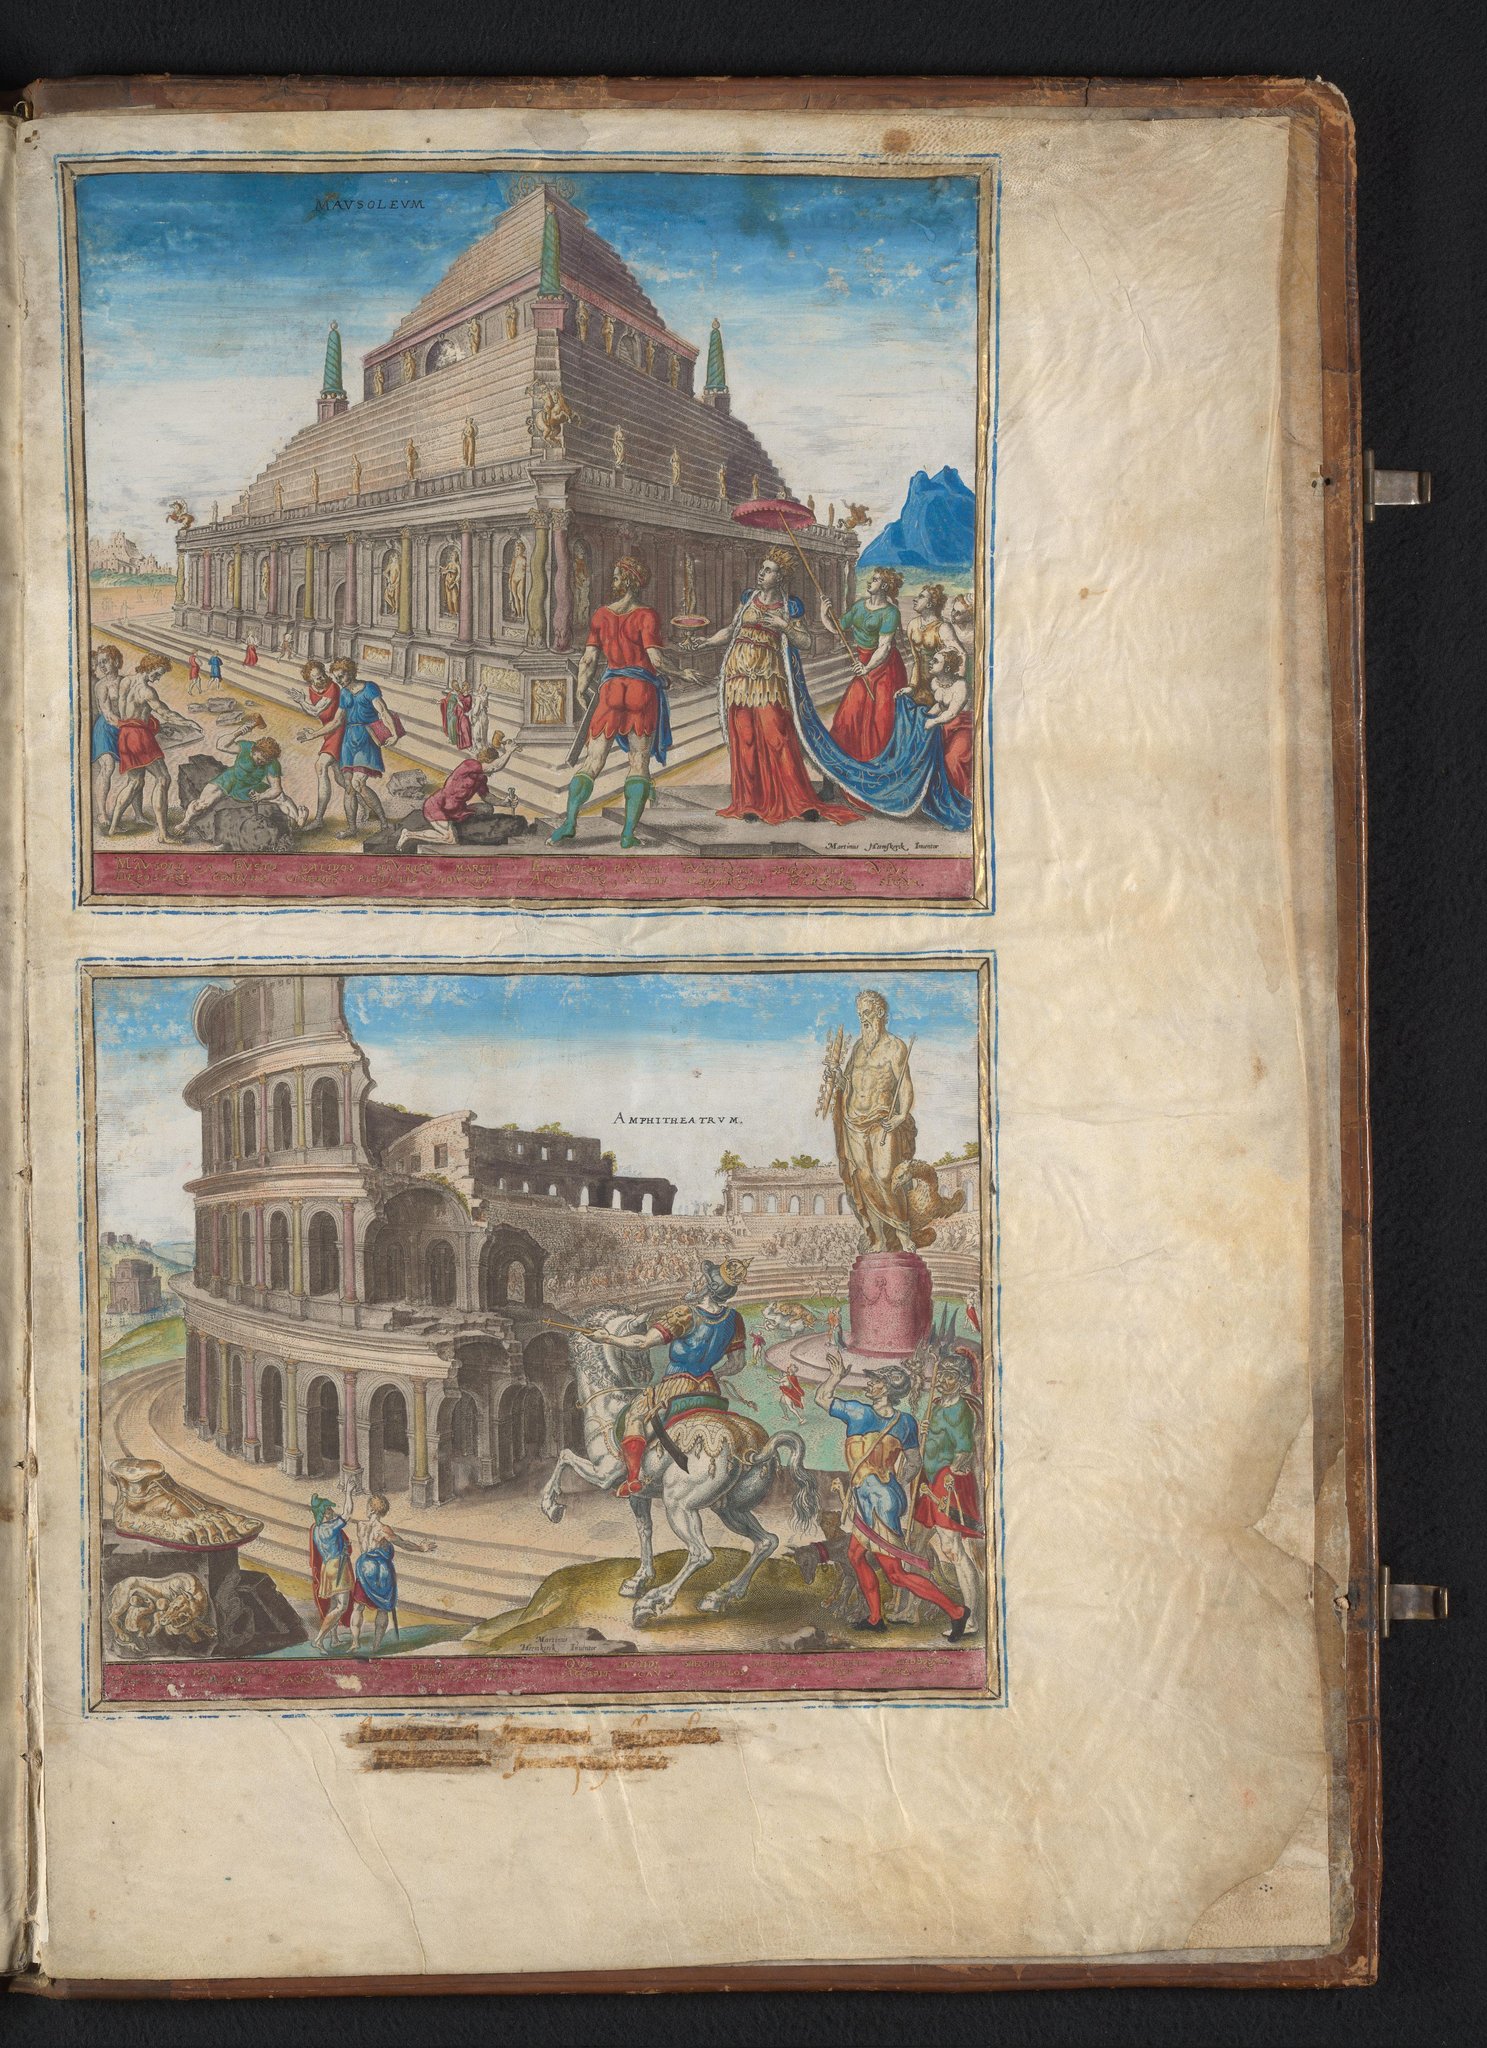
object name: album leaf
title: De acht wereldwonderen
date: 1572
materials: paper, parchment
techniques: engraving, hand coloring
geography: antwerp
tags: vespasian builds the colosseum, other monuments which are sometimes included in the wonders of the world (colosseum)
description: De ruïne van het Romeins Colosseum. Centraal in het Colosseum een standbeeld van Jupiter. Er zijn gevechten aan de gang. In de voorgrond keizer Vespasianus te paard. Hij had opdracht gegeven tot de bouw van het Colosseum. Links in de voorgrond een reliëf met Romulus en Remus, die gezoogd worden door een wolf. Onder de voorstelling een vers in het Latijn. Deze prent maakt deel uit van een album.